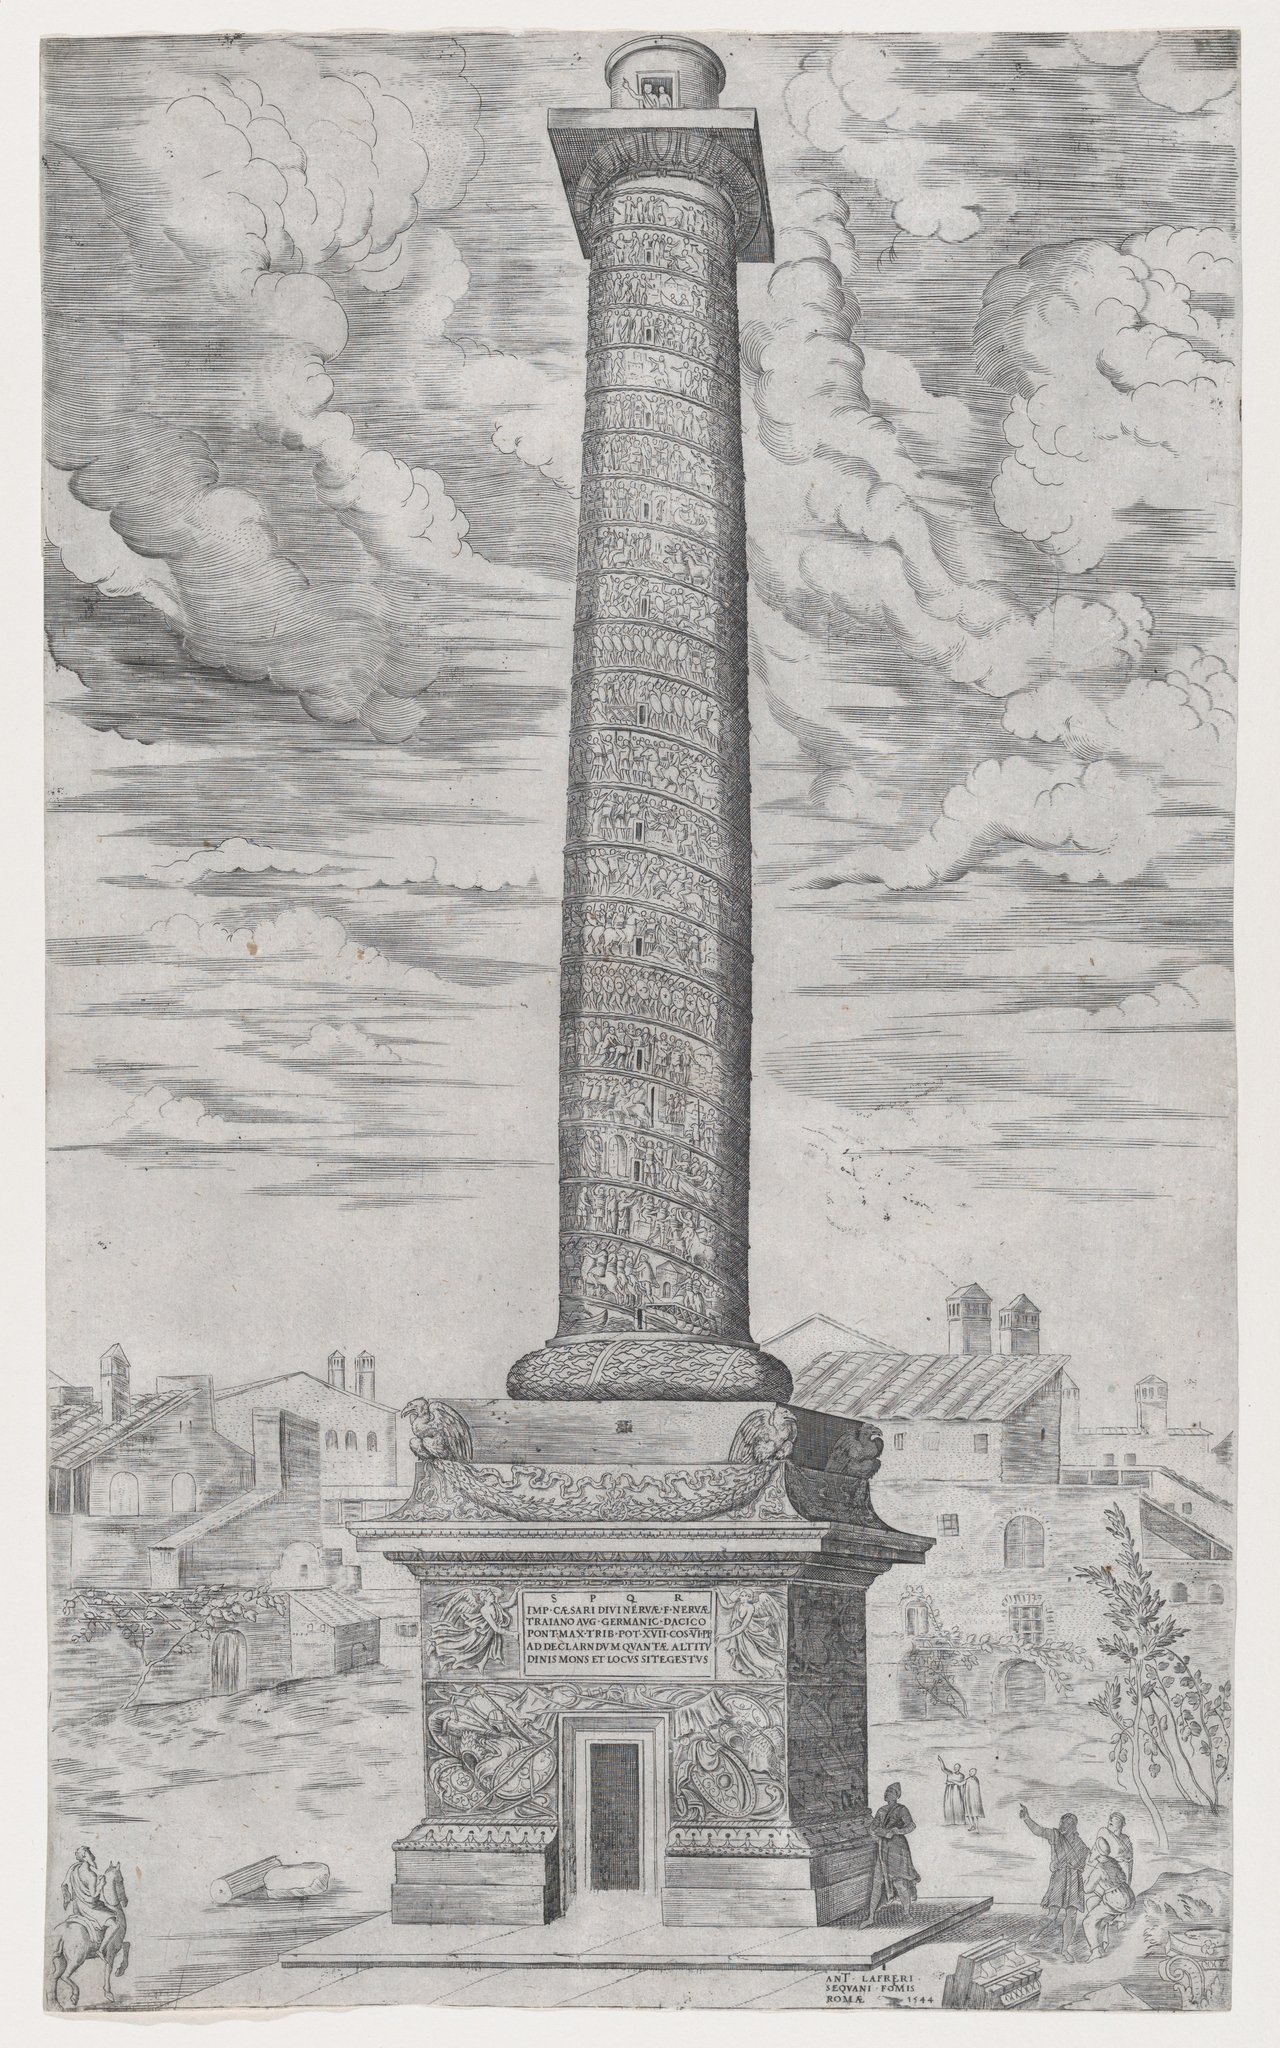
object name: print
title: Column of Trajan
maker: Anonymous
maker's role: artist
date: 1544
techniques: engraving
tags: columns,monuments,rome